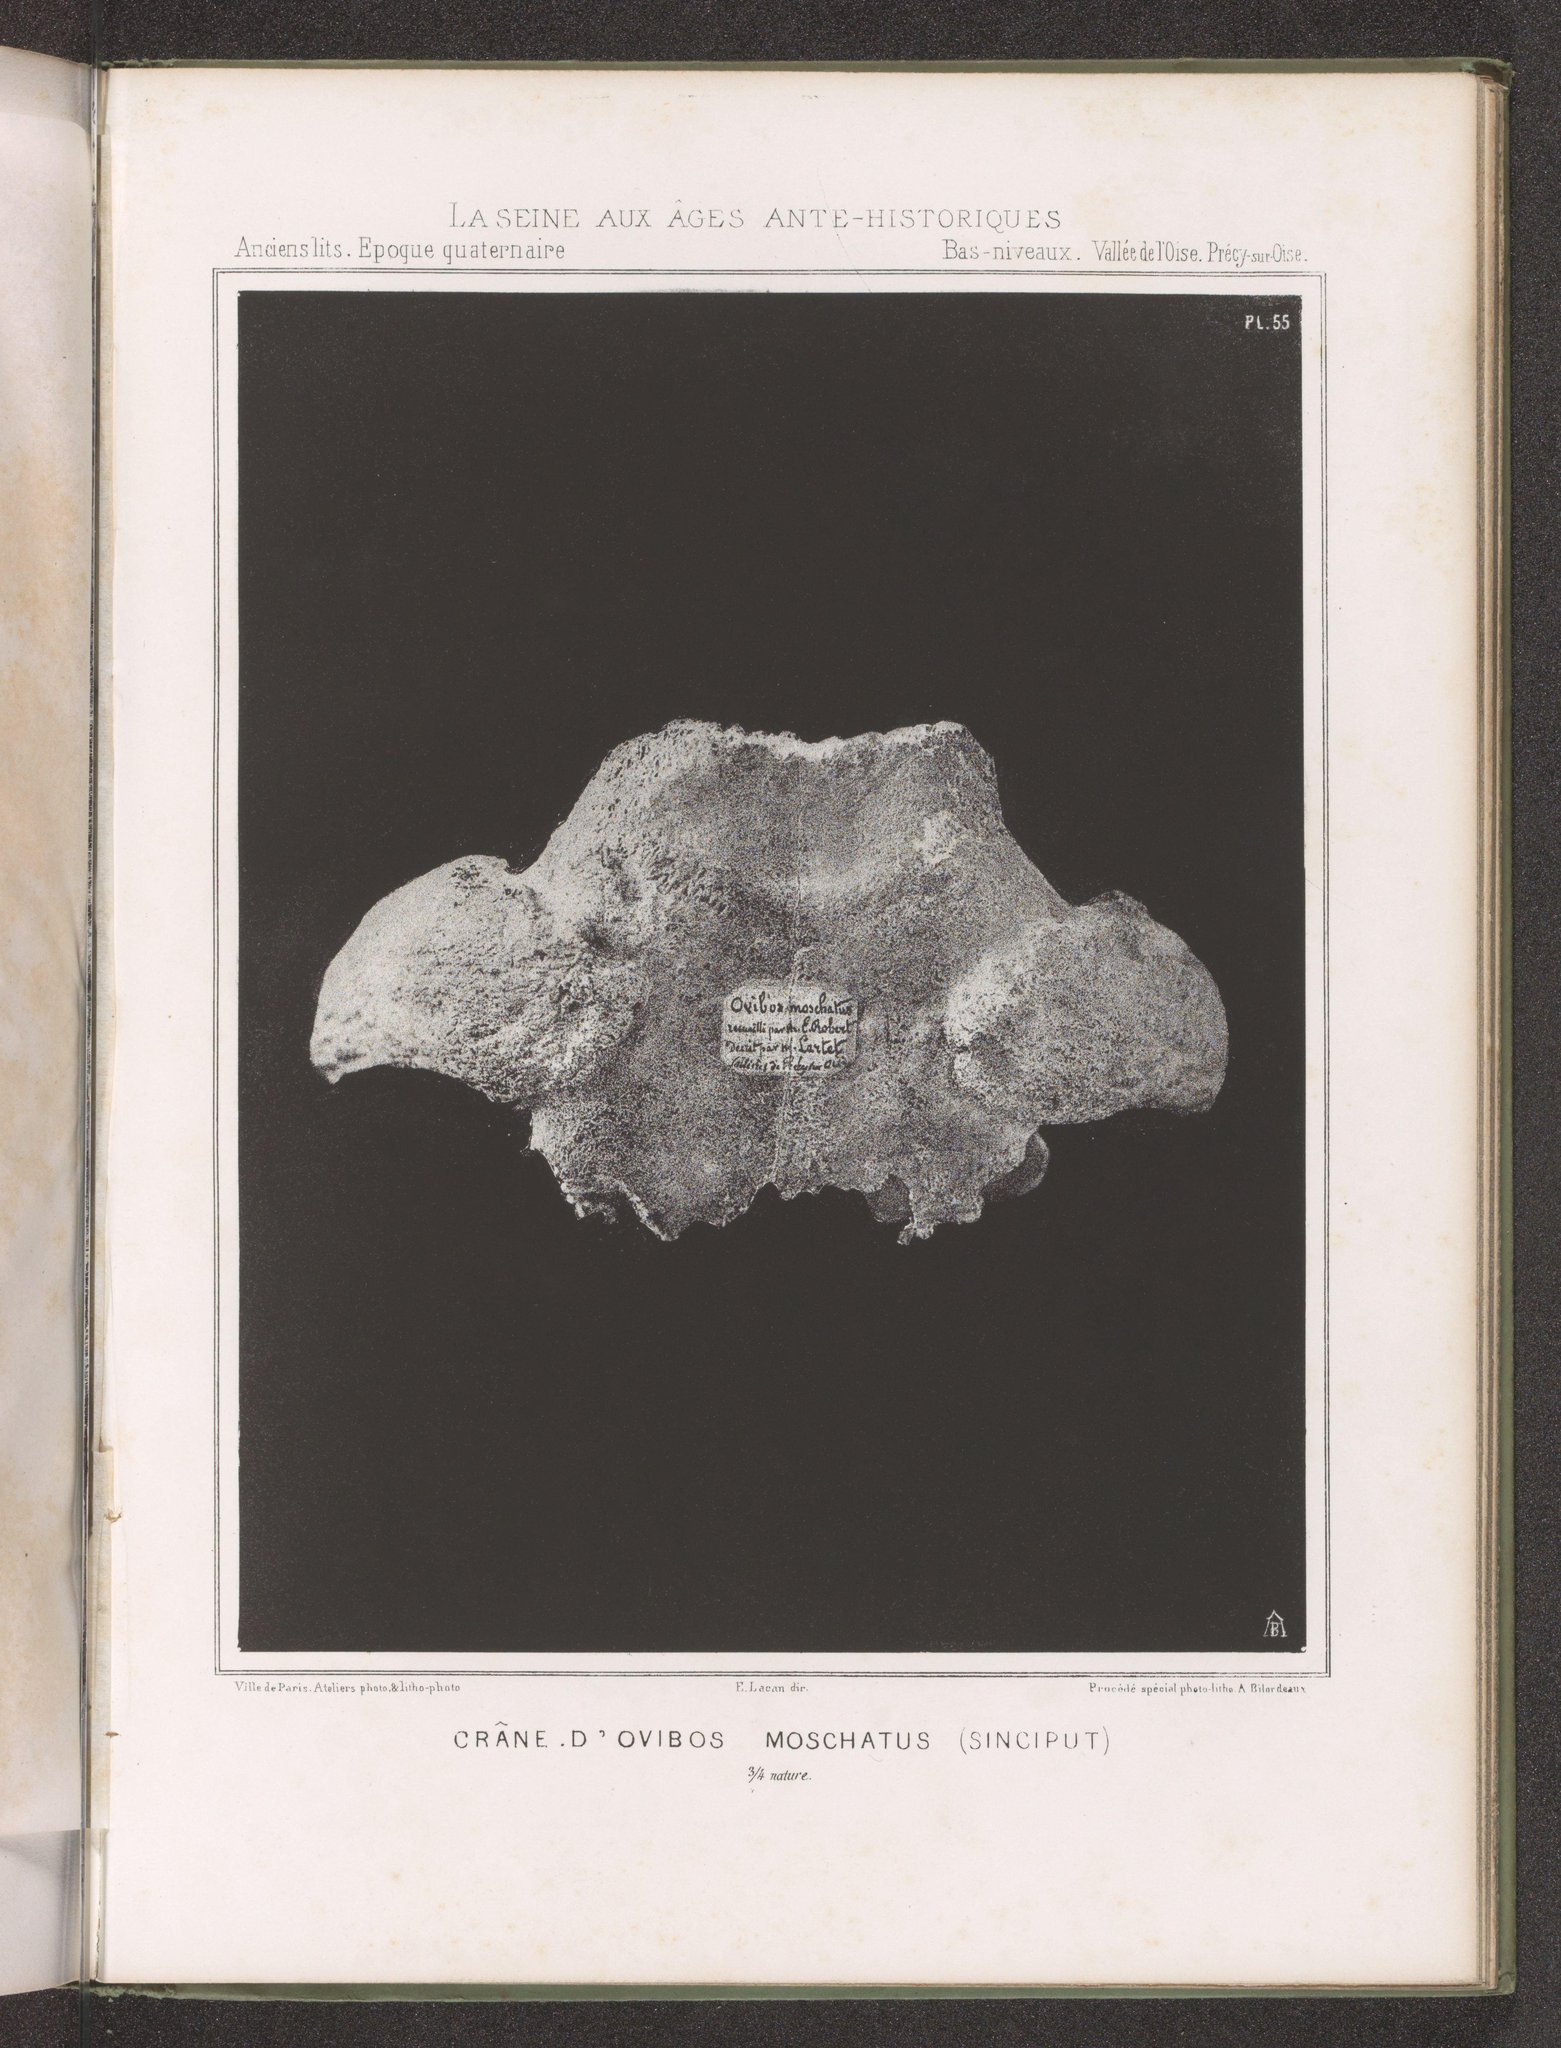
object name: photomechanical print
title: Bovenste deel van de schedel van een muskusos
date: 1860-1869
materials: paper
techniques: photolithography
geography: paris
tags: animals (+ skeleton of an animal), palaeontology, france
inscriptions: number: ‘Pl. 55’, monogram: ‘AB’, inscription: ‘Ville de Paris. Ateliers photo. & litho-photo. E. Lacan dir. Procédé spécial photo-litho A. Bilordeaux.’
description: Voor plek prent in boek: zie nummer onder 'Opschriften / Merken'.